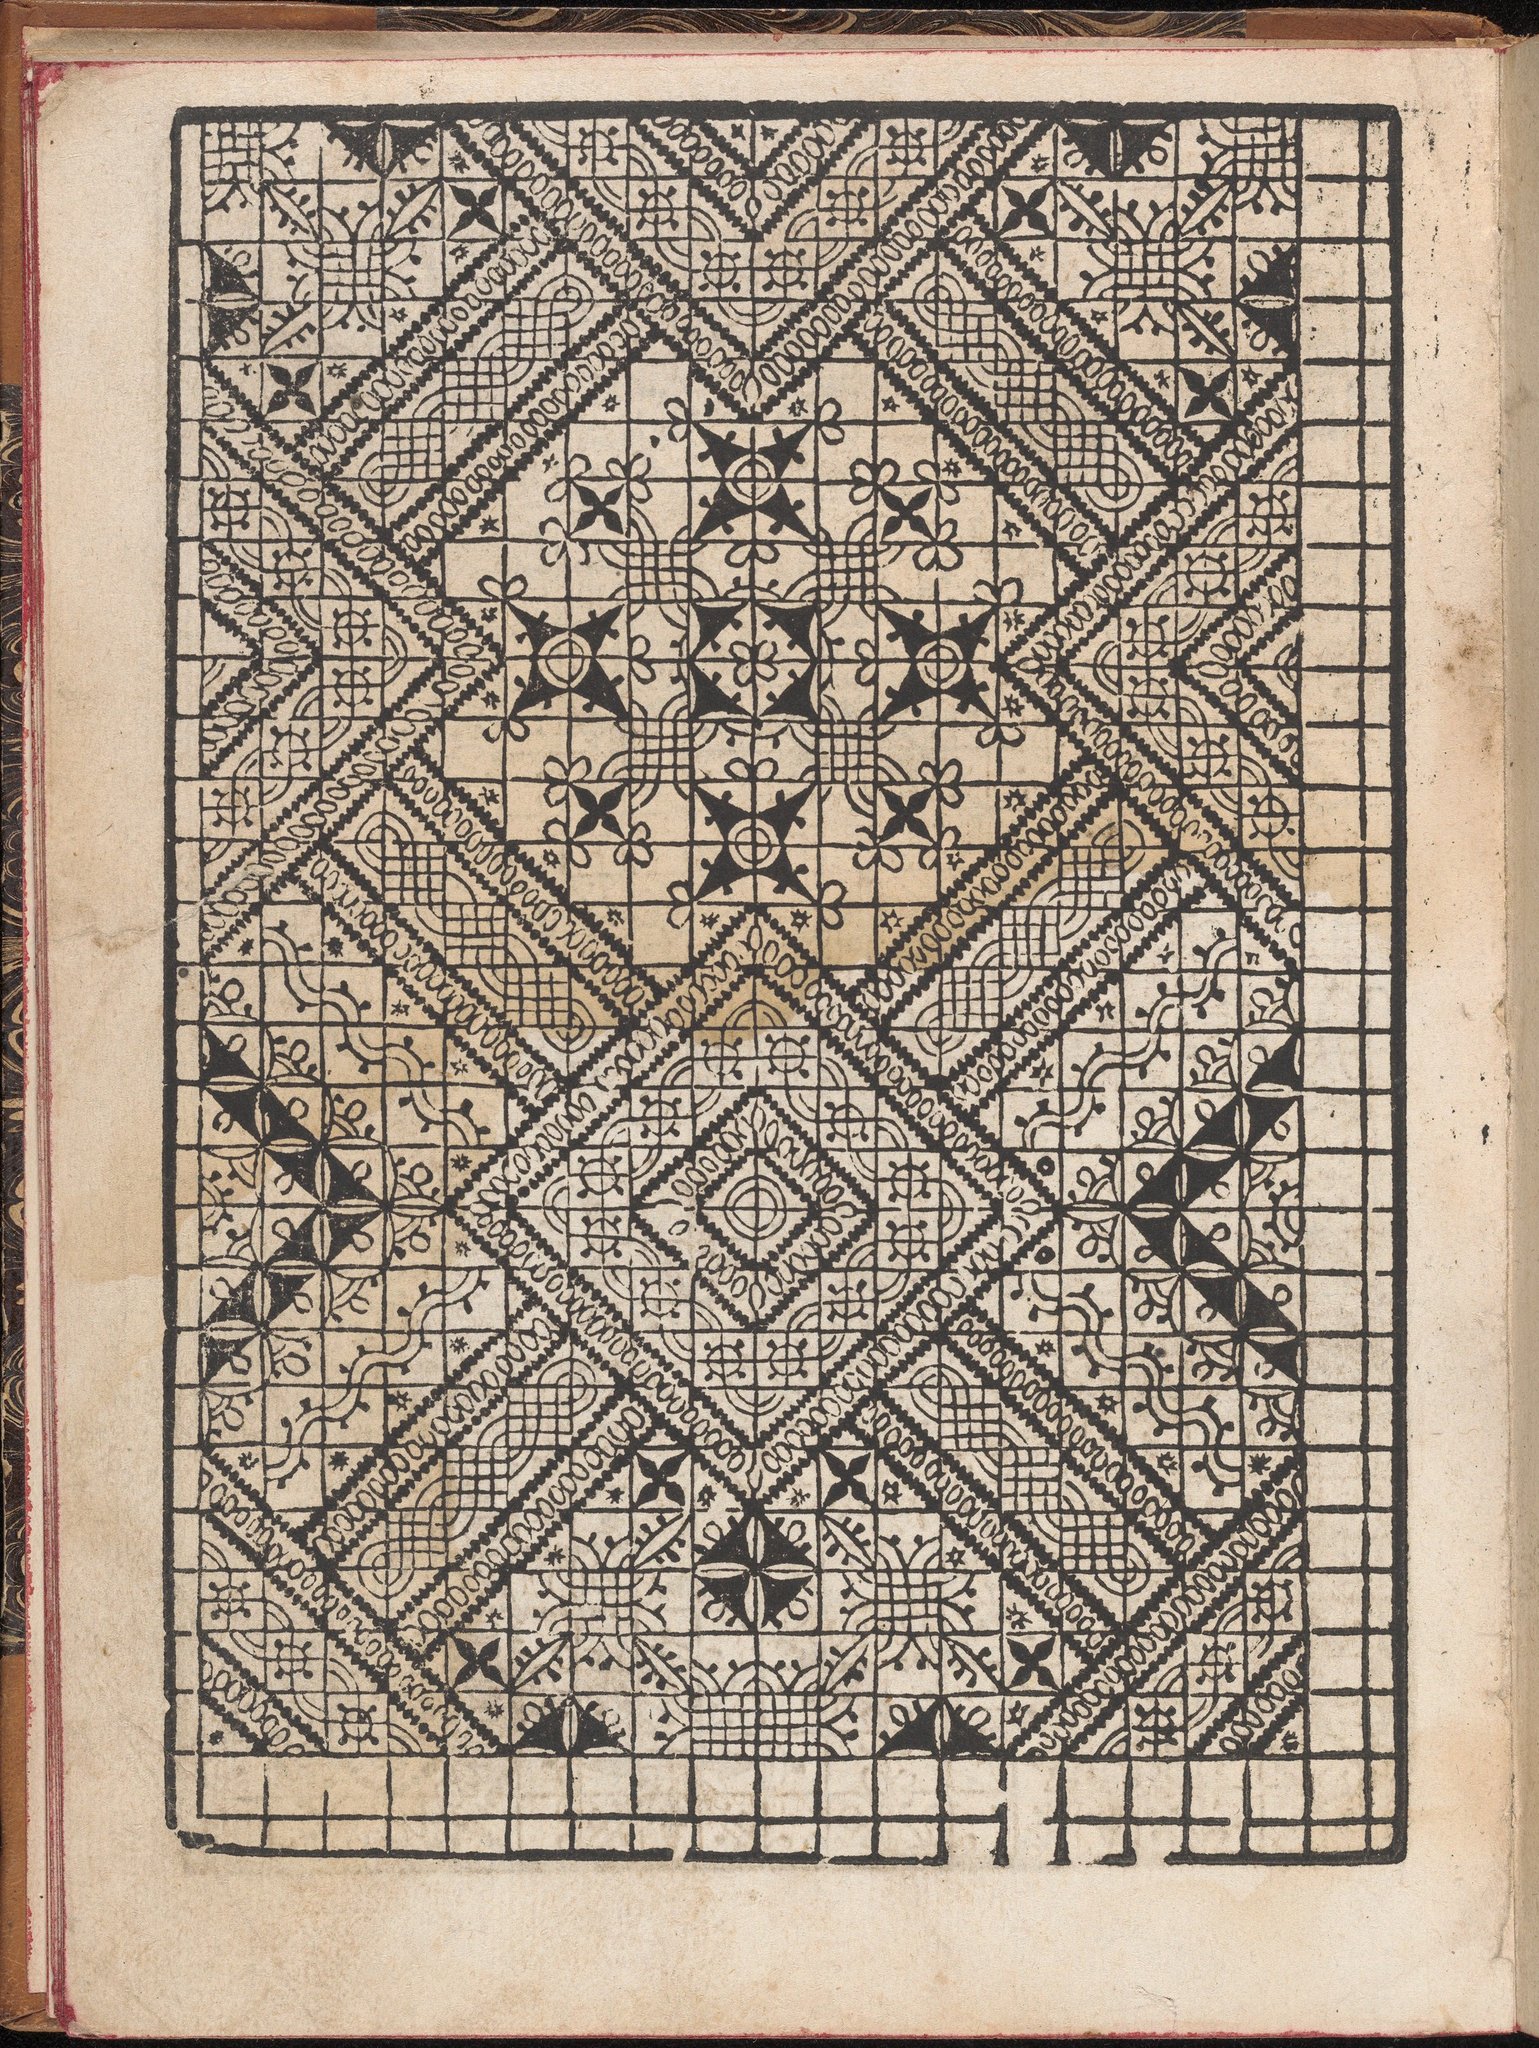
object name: book print ornament architecture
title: Spechio di pensieri delle belle et Virtudiose donne, page 9 (verso)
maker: matteo pagano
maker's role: publisher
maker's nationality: italian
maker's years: 1515-1588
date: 1546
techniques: woodcut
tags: ornament